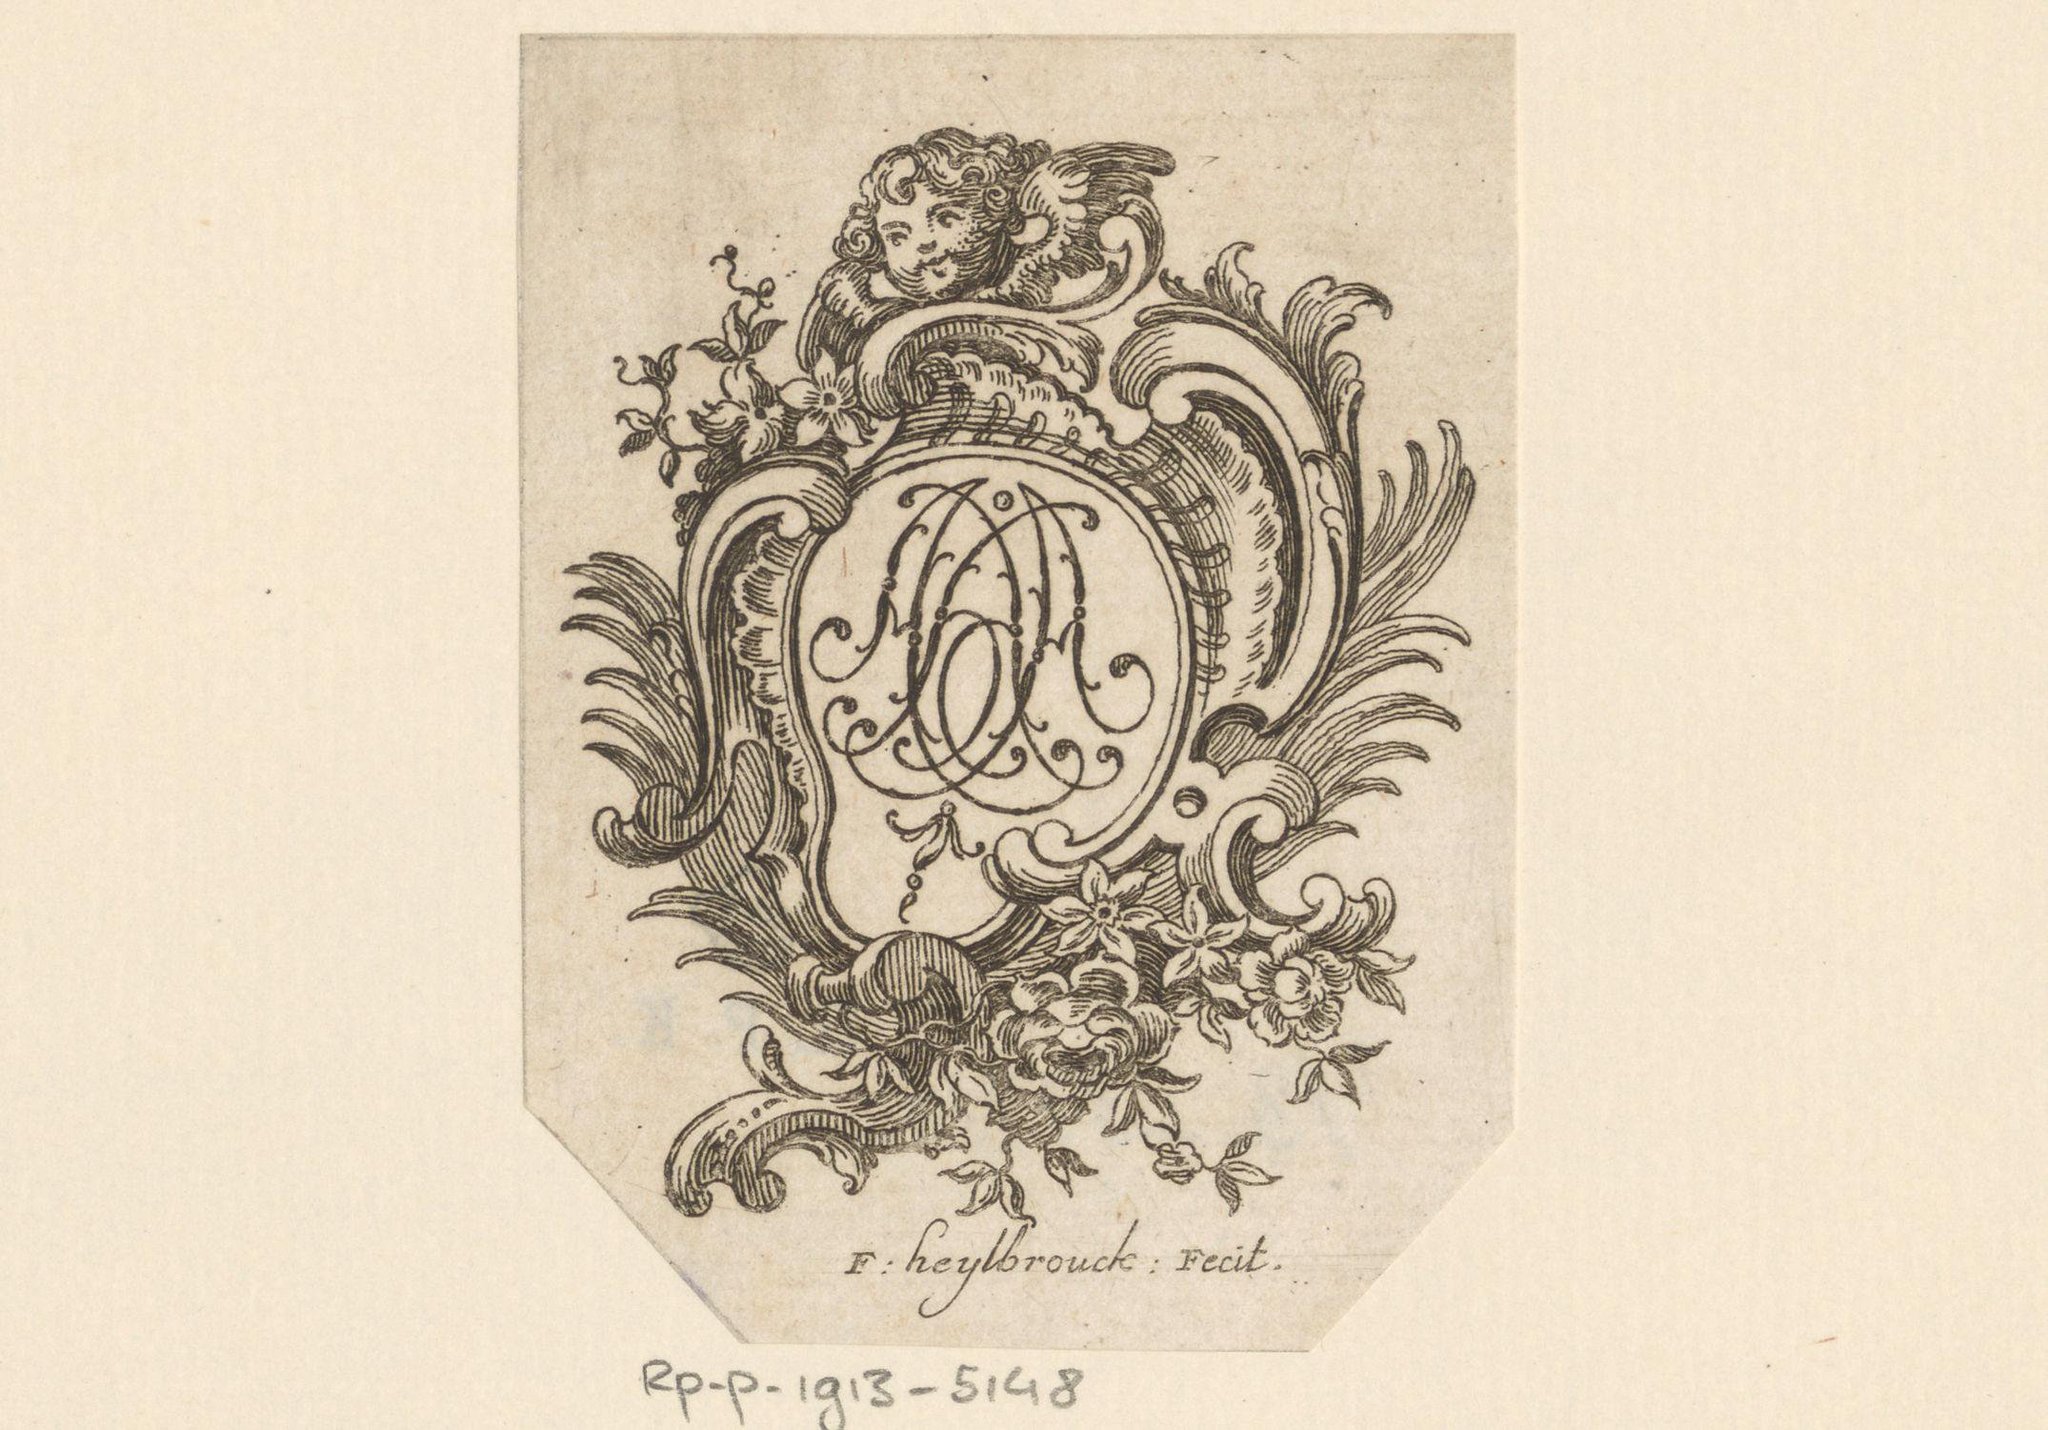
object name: bookplate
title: Ex libris van onbekend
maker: franciscus heylbrouck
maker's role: print maker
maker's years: 1704-1780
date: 1714-1780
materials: paper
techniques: etching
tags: initial, armorial bearing, heraldry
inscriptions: collector's mark: Lugt 2760, collector's mark: Lugt 2233